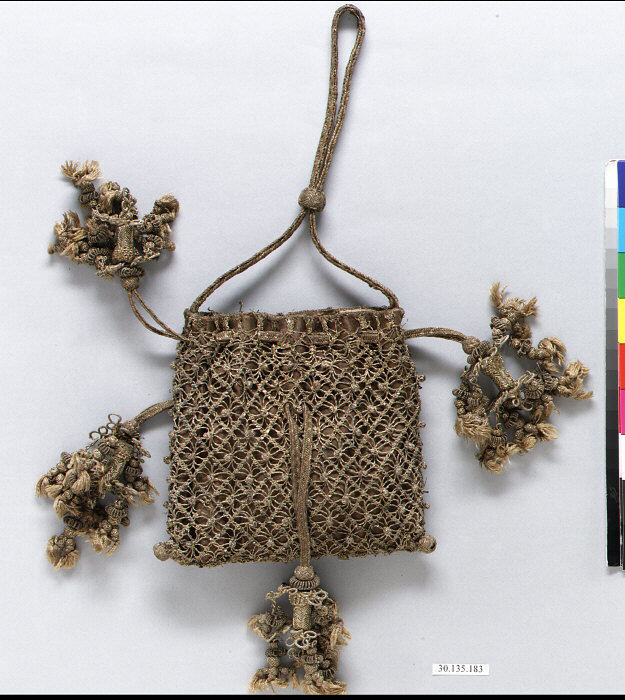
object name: bag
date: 1601-1700